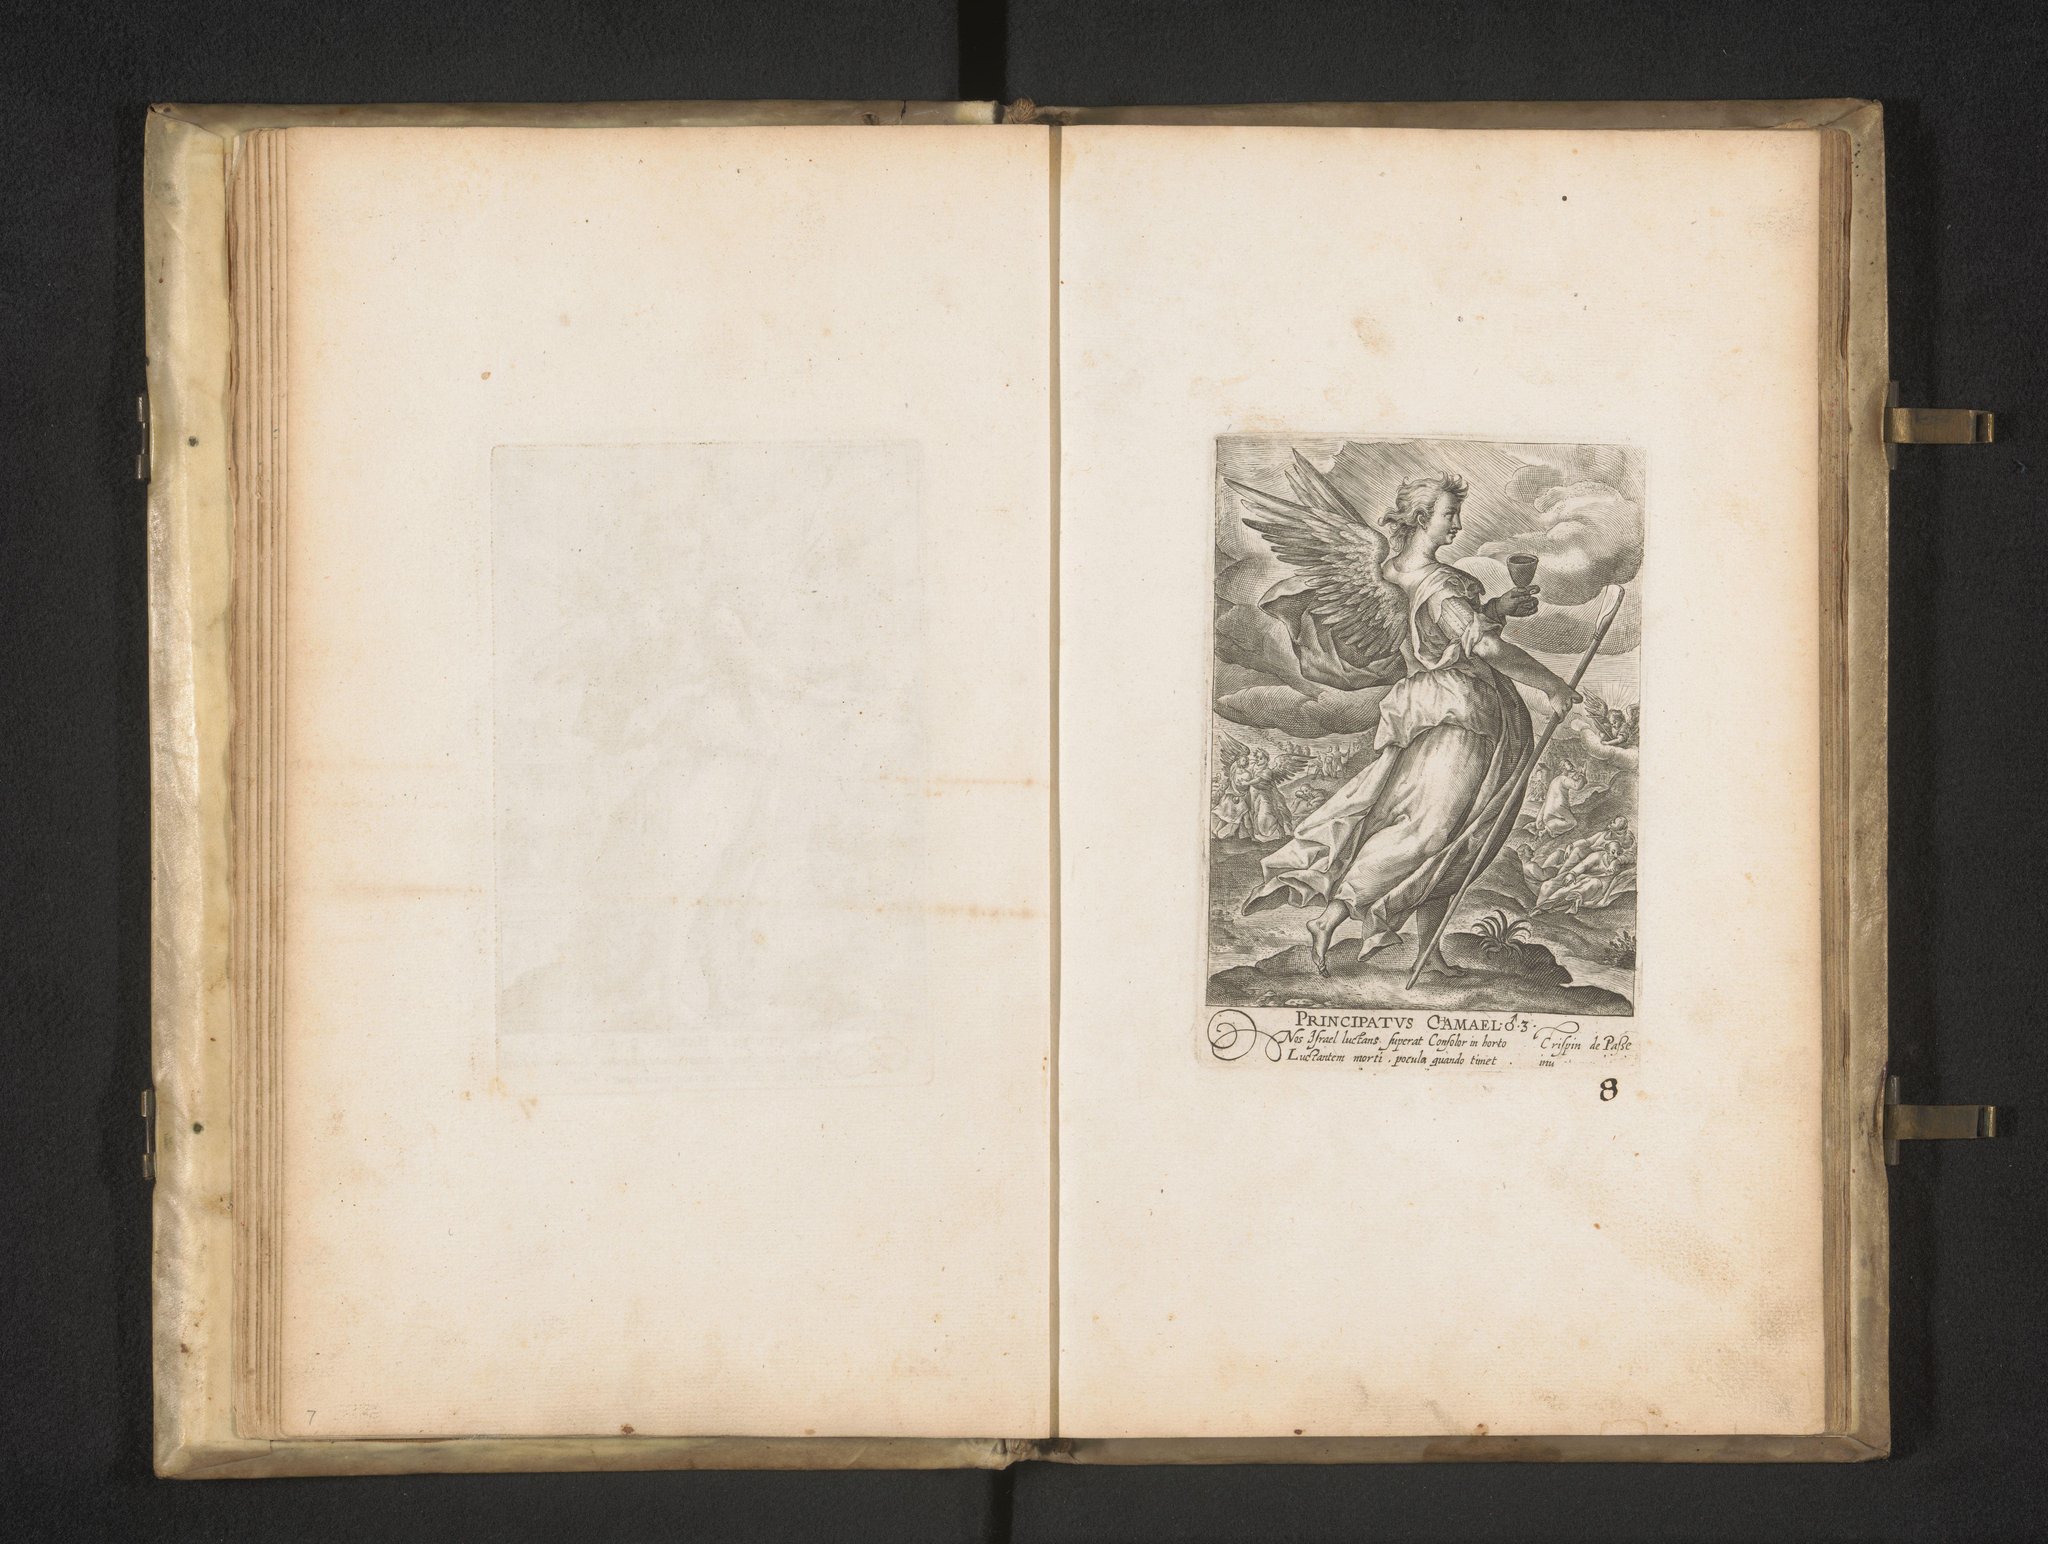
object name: print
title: Principatus Camael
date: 1585-1637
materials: paper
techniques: engraving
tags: agony of christ; three (or eleven) apostles sleeping, other archangels than michael, gabriel and raphael (with name), pilgrimage, pilgrim(s) under way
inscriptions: number: ‘8’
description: Aartsengel Chamuël met staf en kelk. Links op de achtergrond ondersteunt Chamuël bedevaartgangers. Rechts op de achtergrond bidt Christus in het Hof van Olijven. Genummerd in het inderschrift: 3. Maakt in dit album deel uit van een serie van twaalf voorstellingen van aartsengelen en andere engelen. Onderdeel van een album met voornamelijk christelijke voorstellingen.